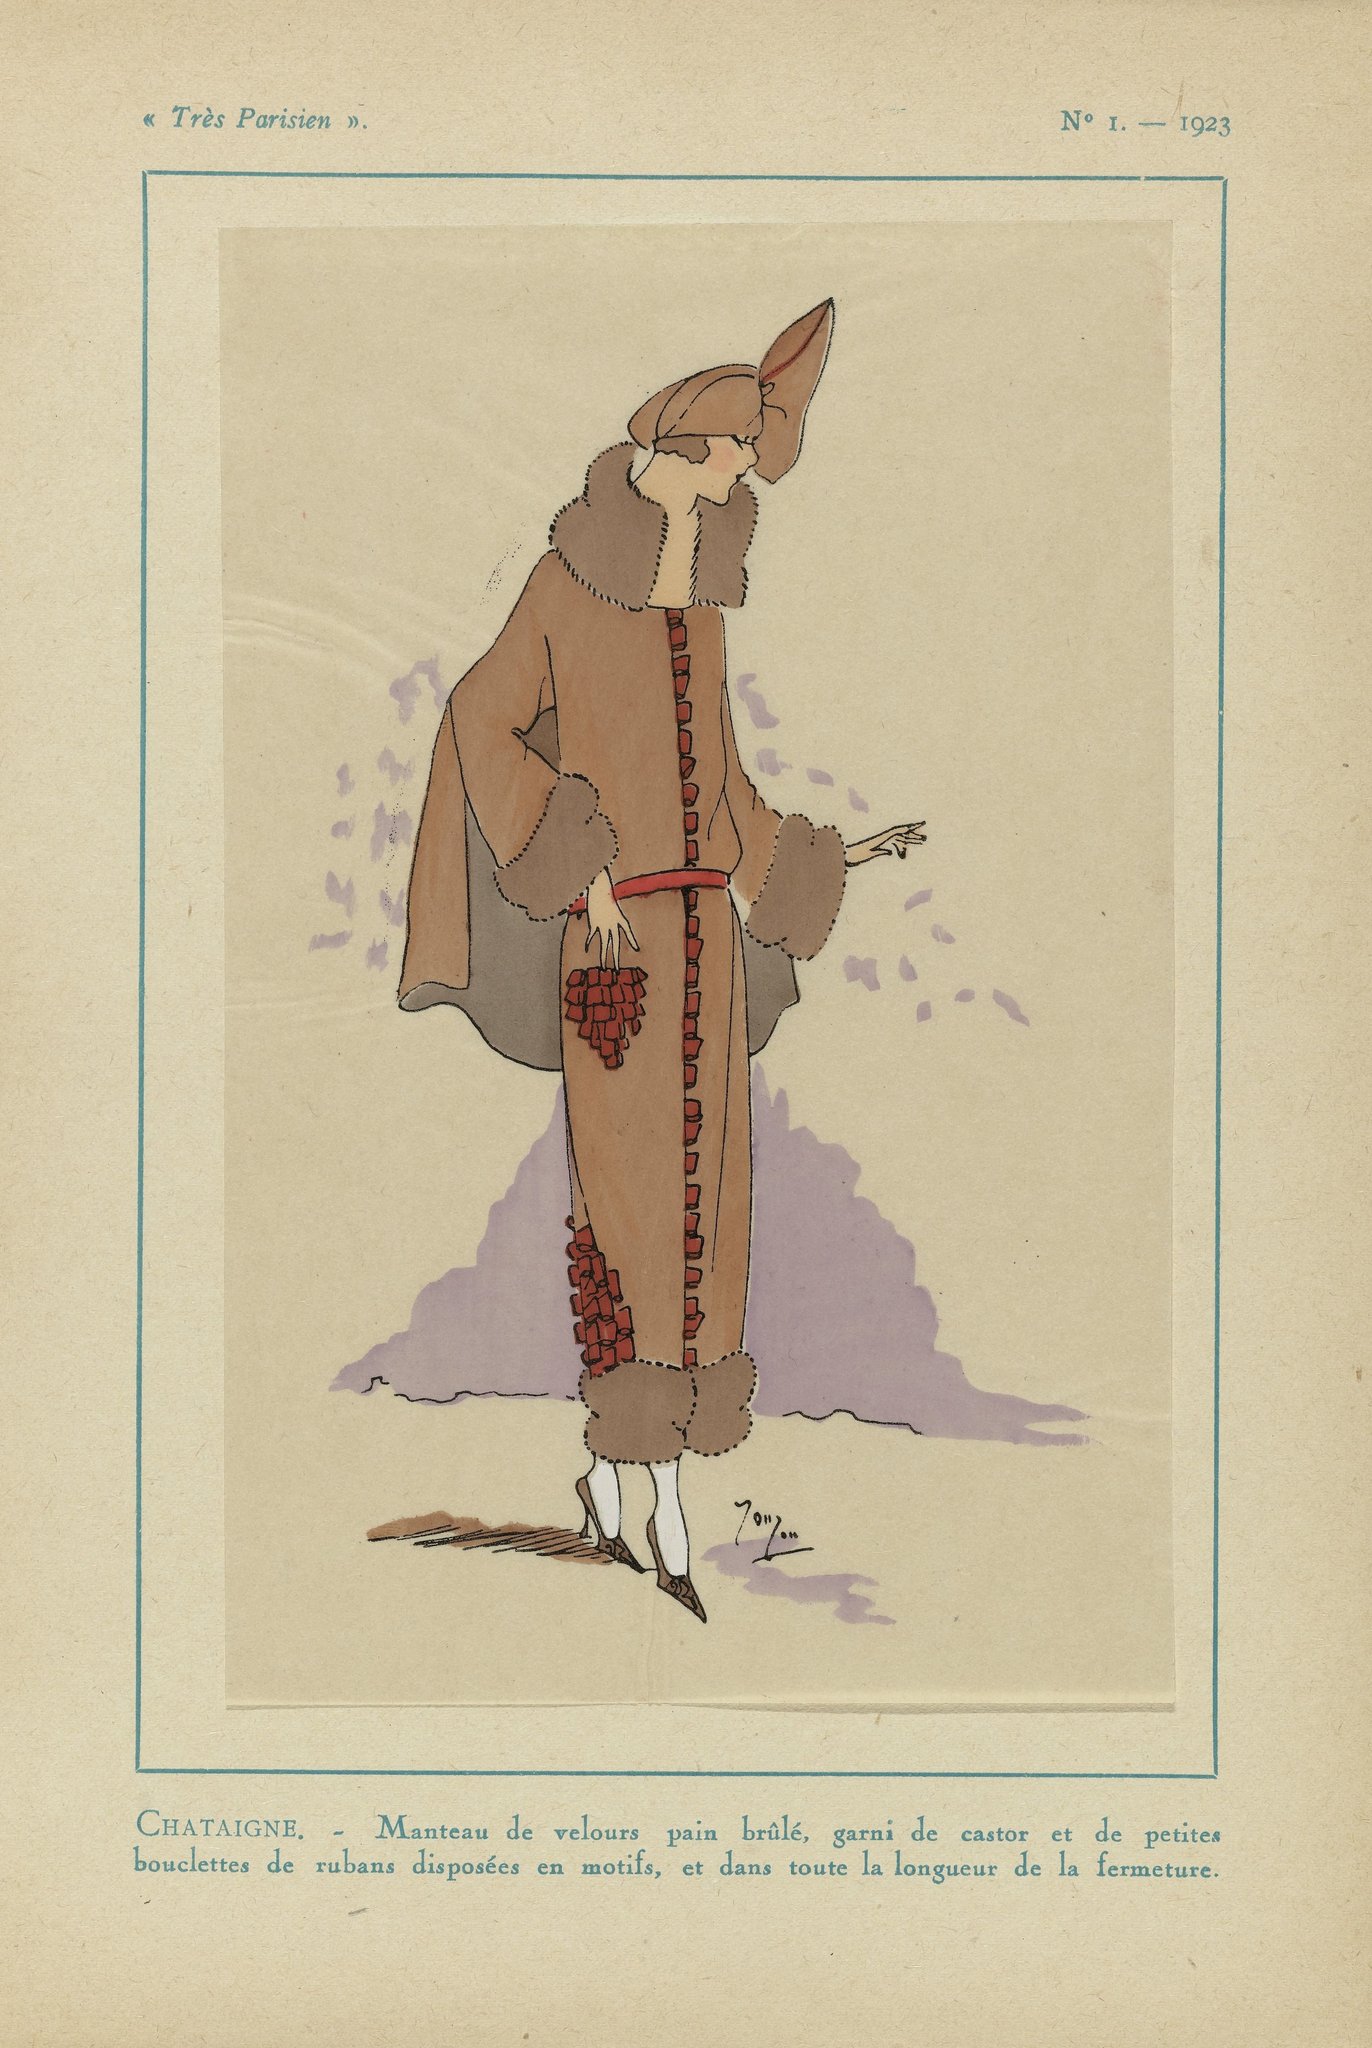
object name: fashion print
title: Très Parisien, 1923, No 1: CHATAIGNE. - Manteau de velours...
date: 1923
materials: paper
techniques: hand coloring, letterpress printing, lithography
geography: paris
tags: border, ribbon, braid (+ women's clothes), border, ribbon, braid (+ fur used for clothes), coat (+ women's clothes), fashion plates, head-gear: hat (+ women's clothes)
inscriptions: caption: ‘CHATAIGNE. - Manteau de velours pain brûlé, garni de castor et de petites bouclettes de rubans disposées en motifs, et dans toute la longueur de la fermeture.’, title: ‘Très Parisien / No 1. - 1923’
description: Mantel van bruin fluweel, gegarneerd met beverbont. Prent uit het modetijdschrift Très Parisien (1920-1936).